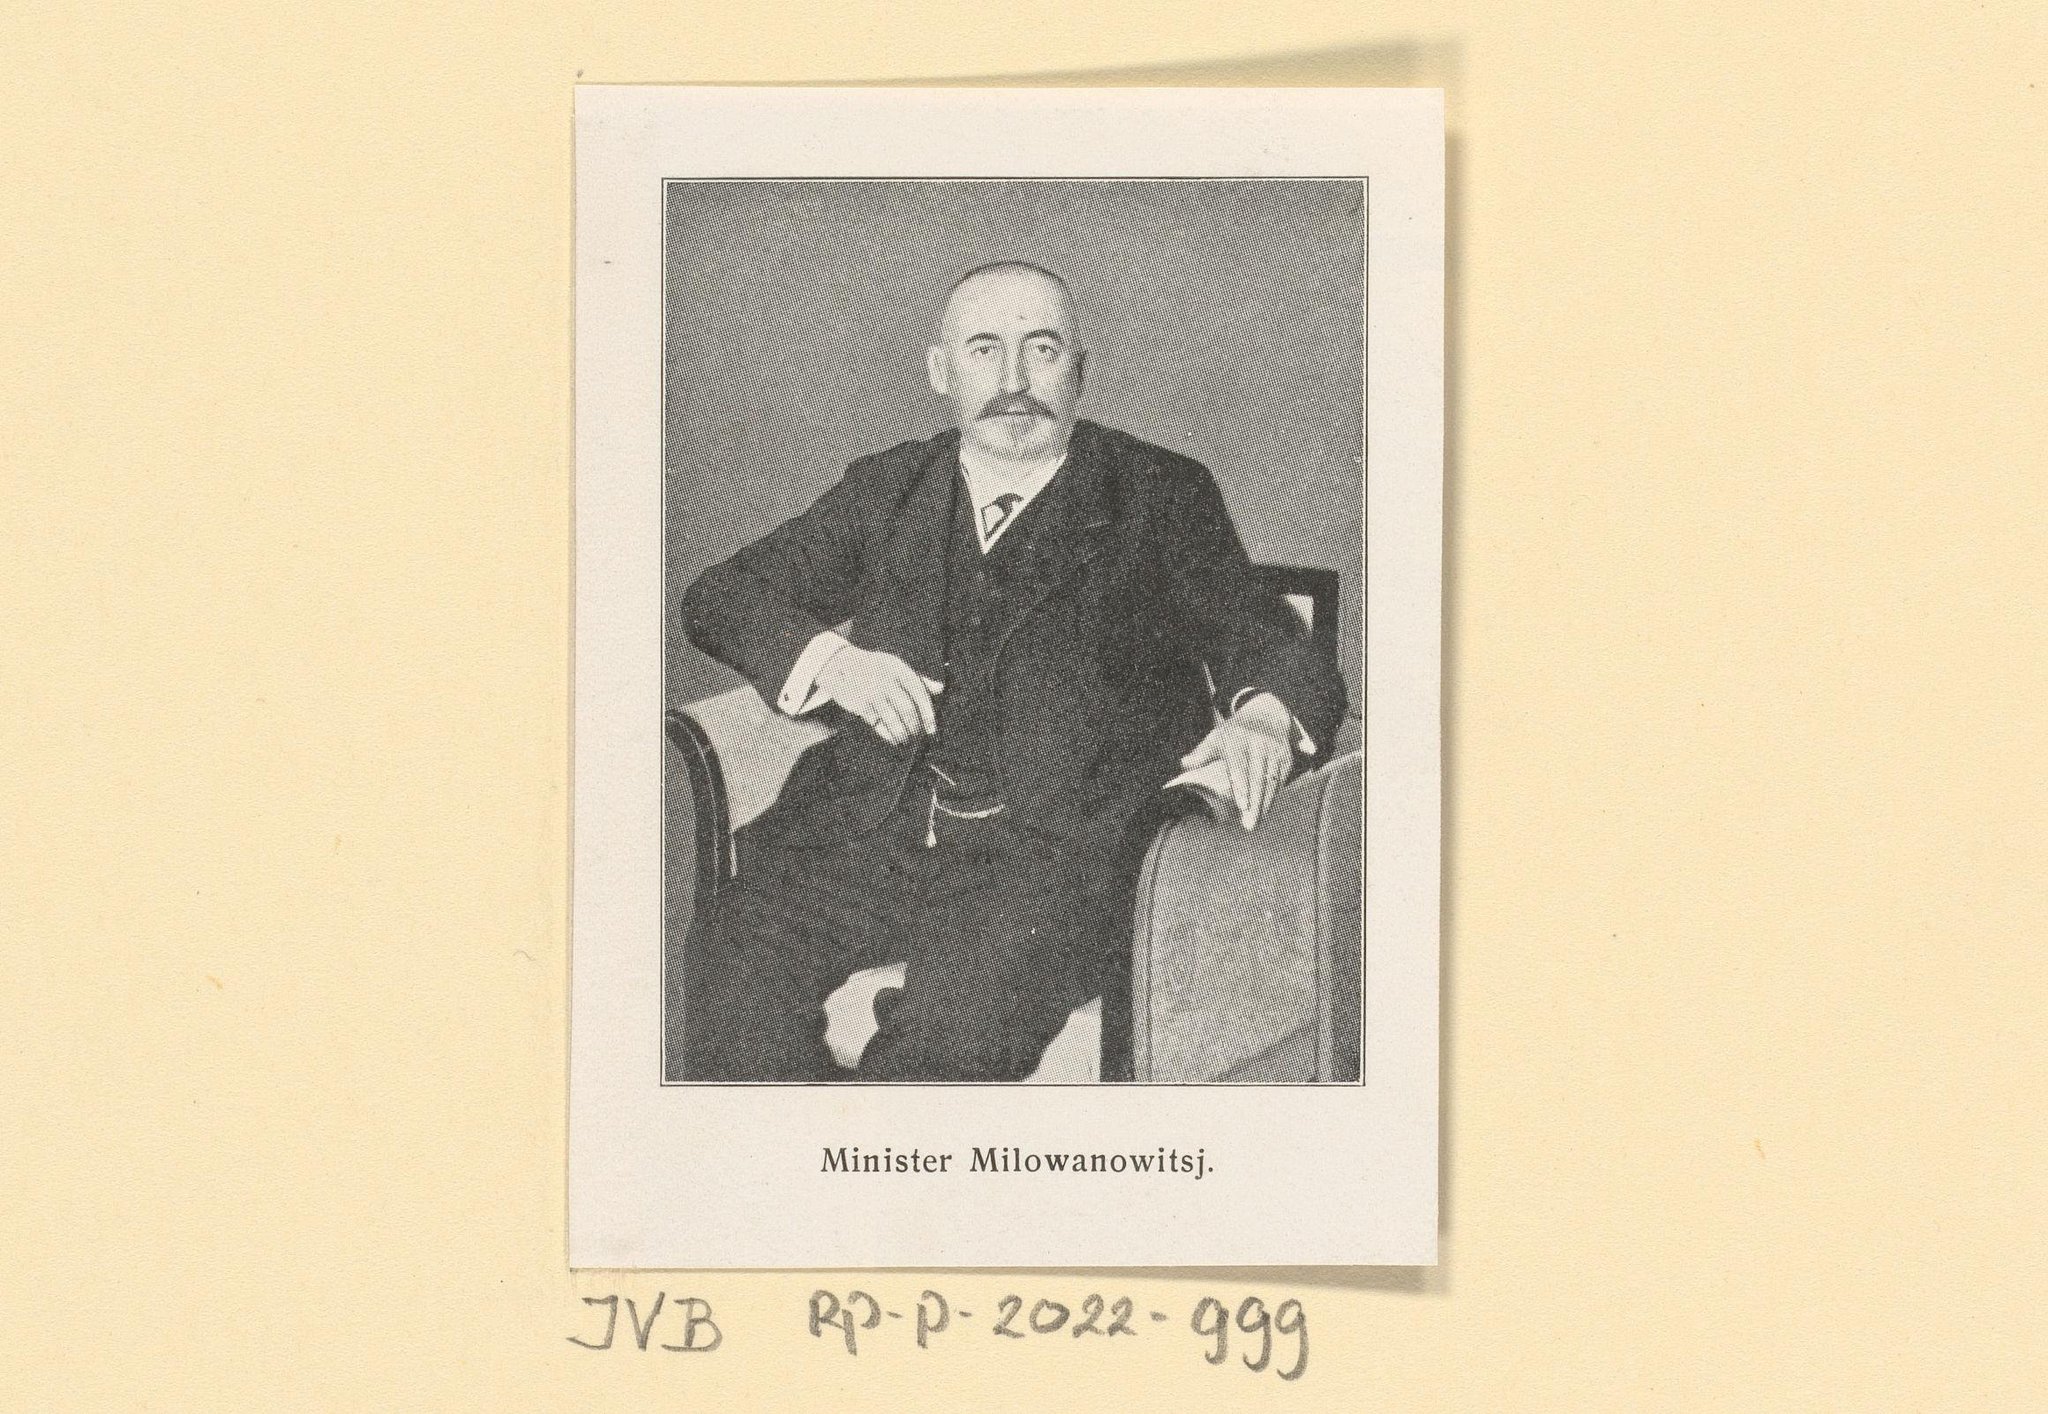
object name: clipping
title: Minister Milowanowitsj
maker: Anonymous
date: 1912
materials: paper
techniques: autotype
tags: minister ~ government, historical persons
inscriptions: collector's mark: ‘JVB’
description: Afdruk uit: Op de hoogte 9 (1912), augustus 1912.